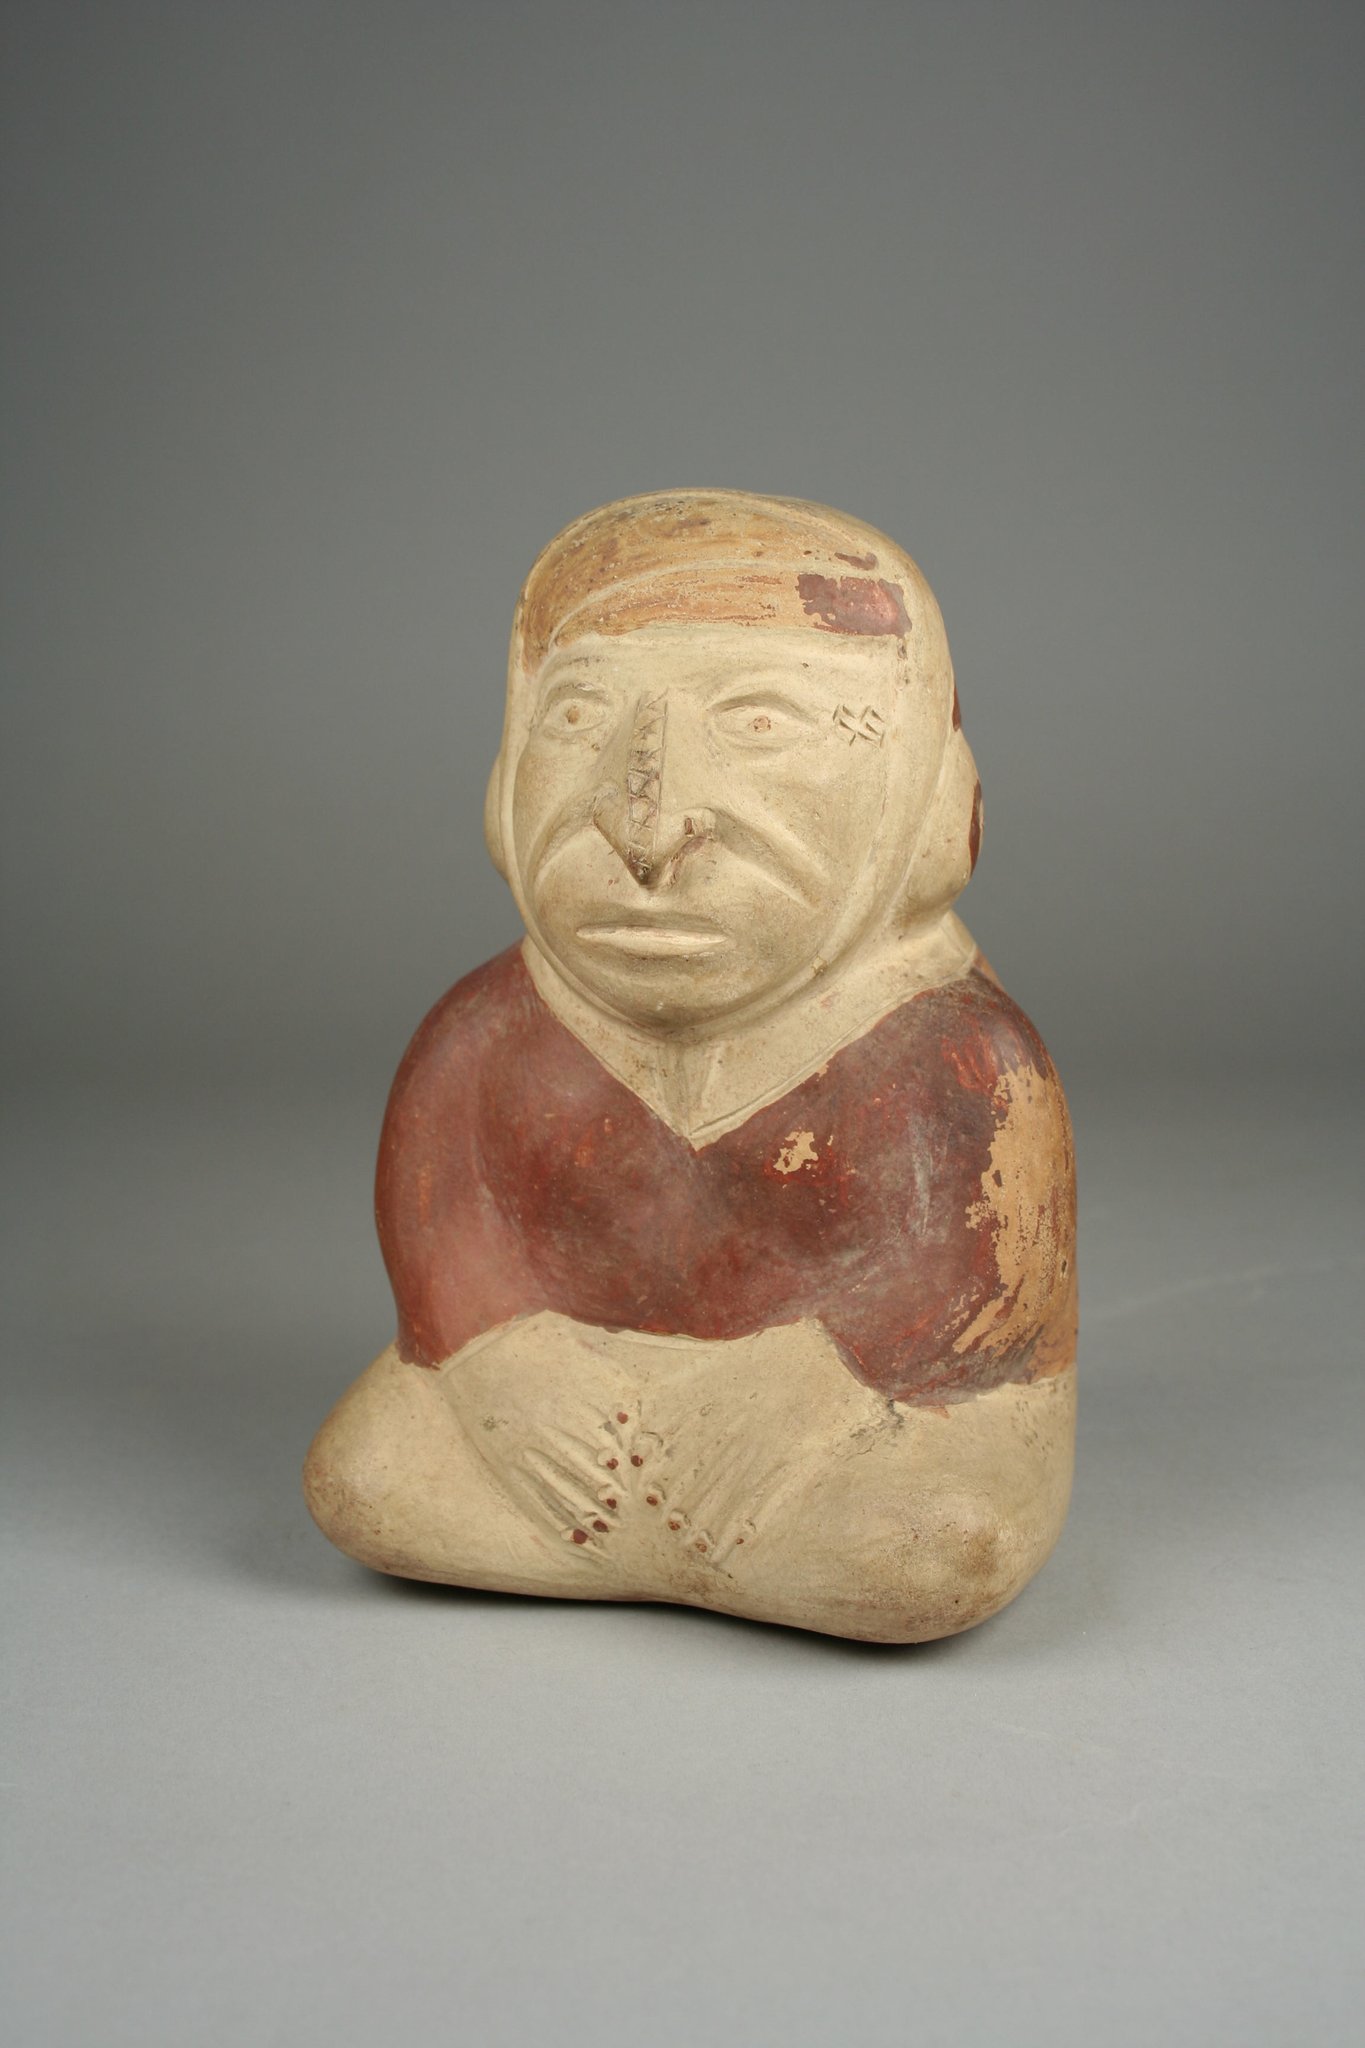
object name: bottle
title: Stirrup Spout Bottle with Figure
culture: moche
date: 201-700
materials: ceramic, pigment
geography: peru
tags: men